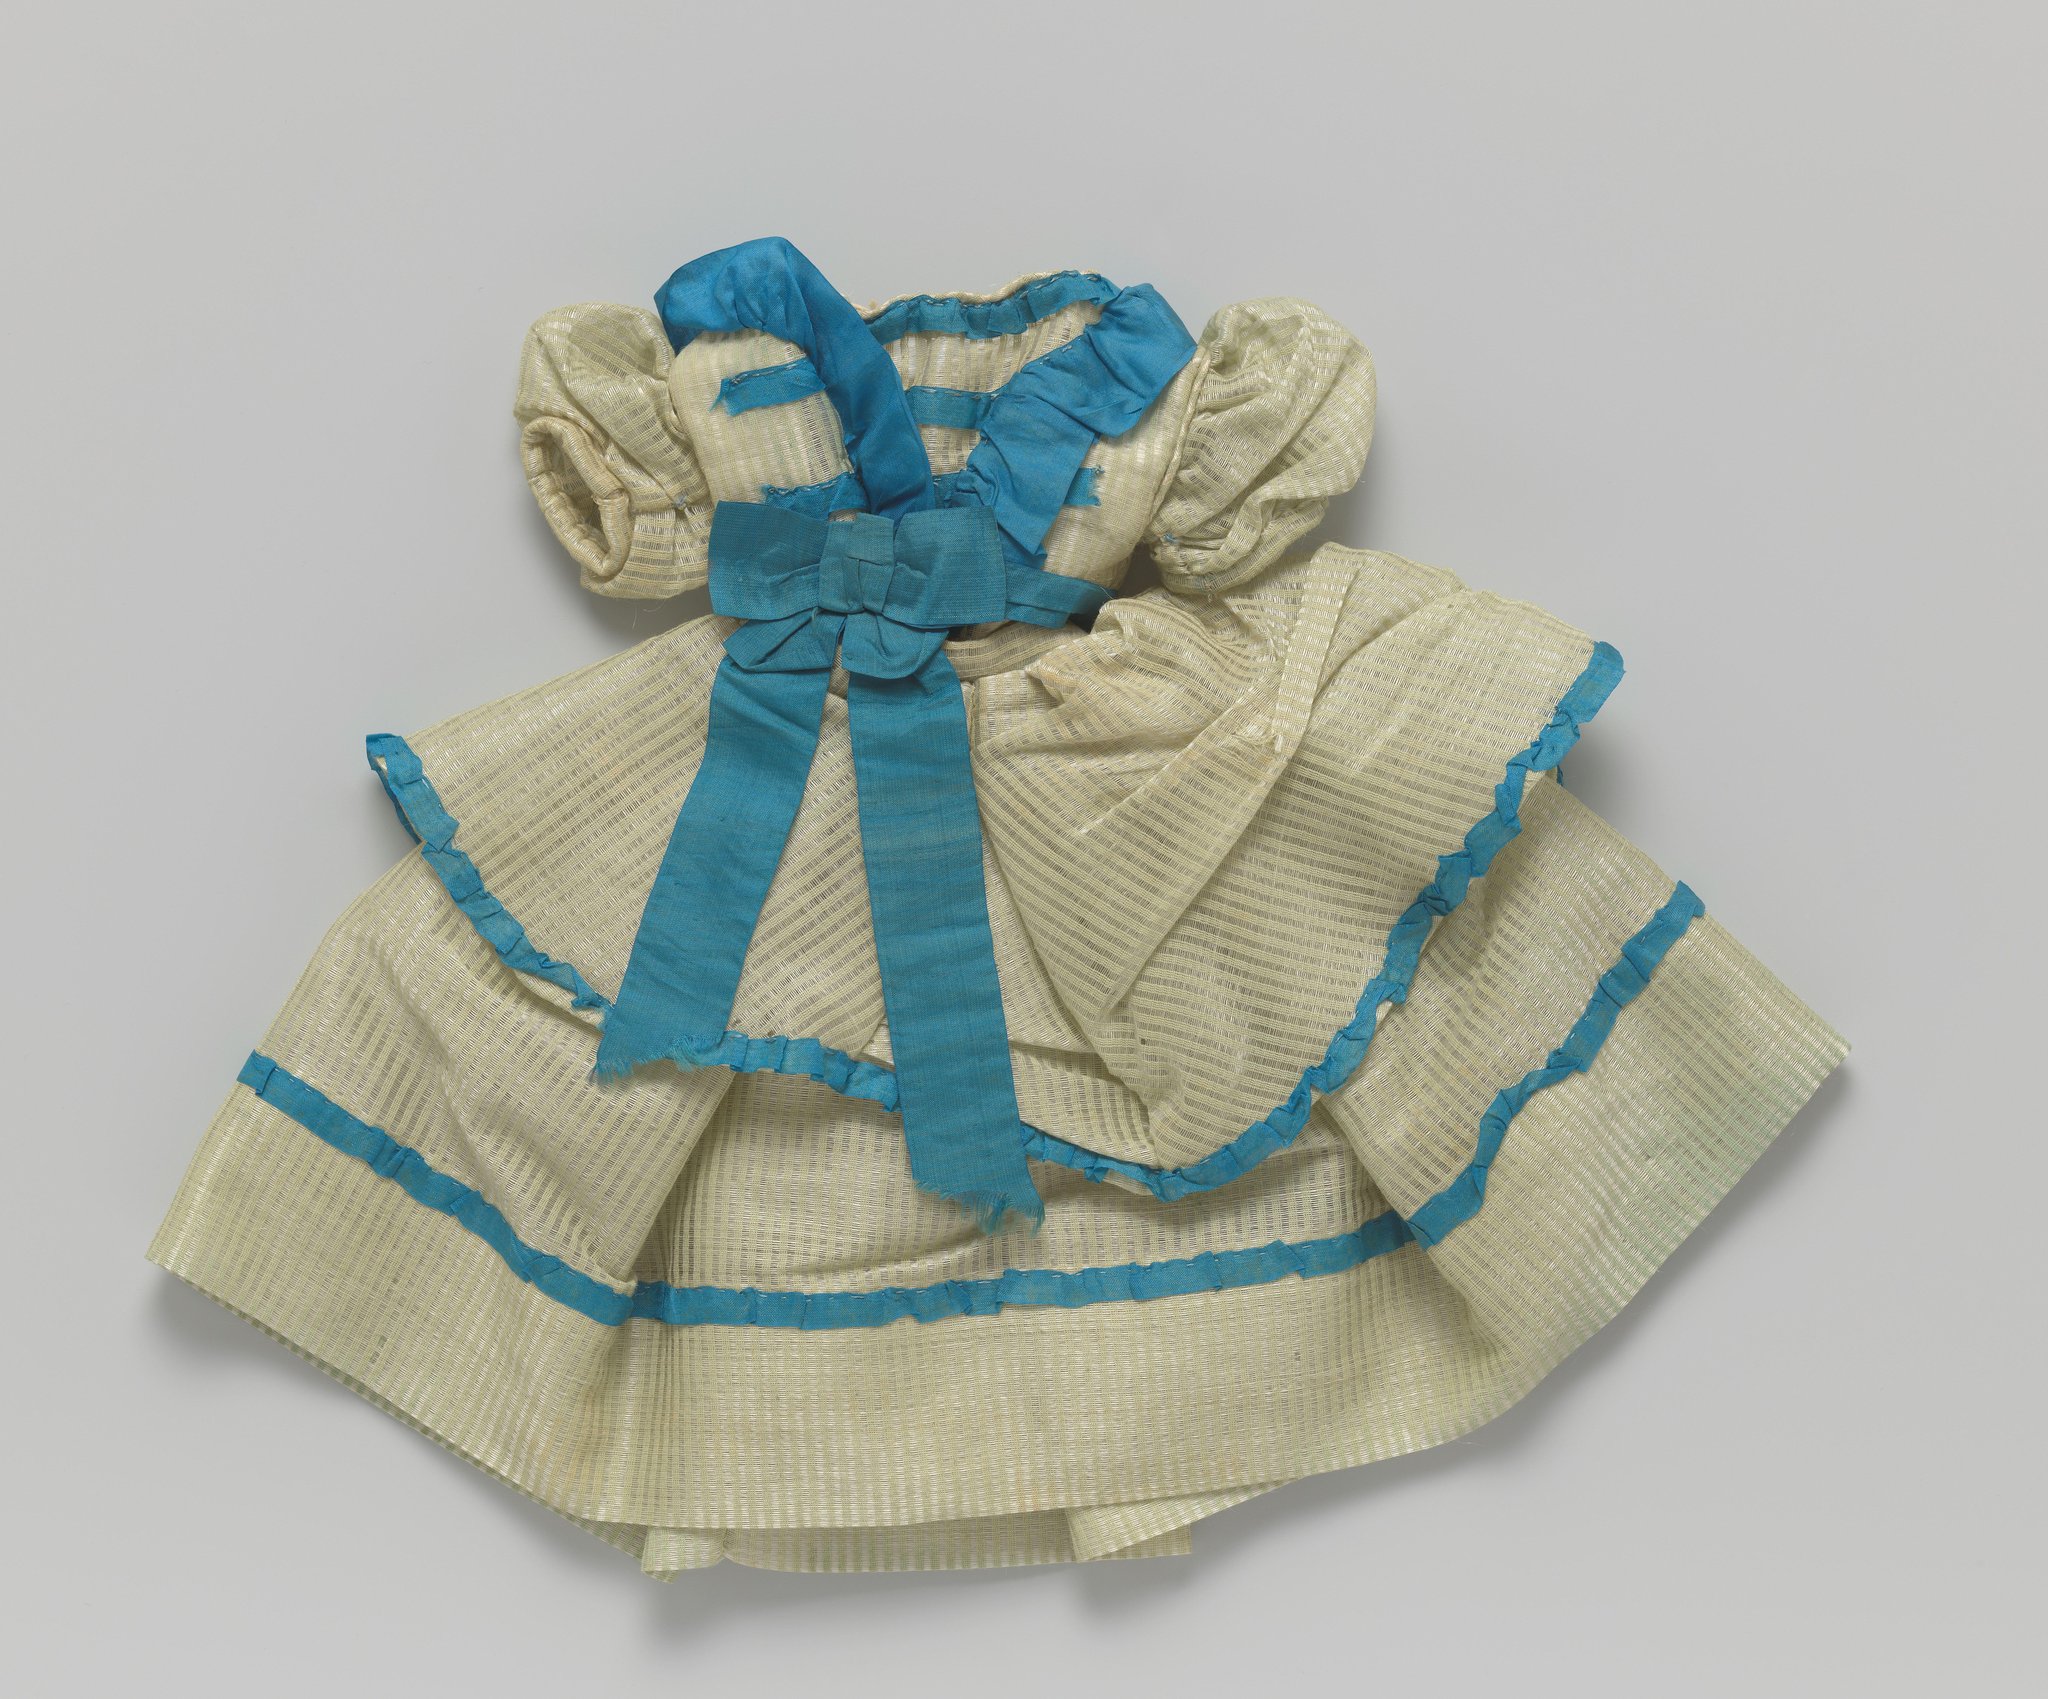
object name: robe, japon, jurk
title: Japon met korte pofmouwen van lichtgroene zijde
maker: Anonymous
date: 1850-1920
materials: metal, silk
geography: europe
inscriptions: number: ‘RBK15445’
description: De japon is voorzien van blauwe biesjes en een blauwe strik aan de achterzijde.